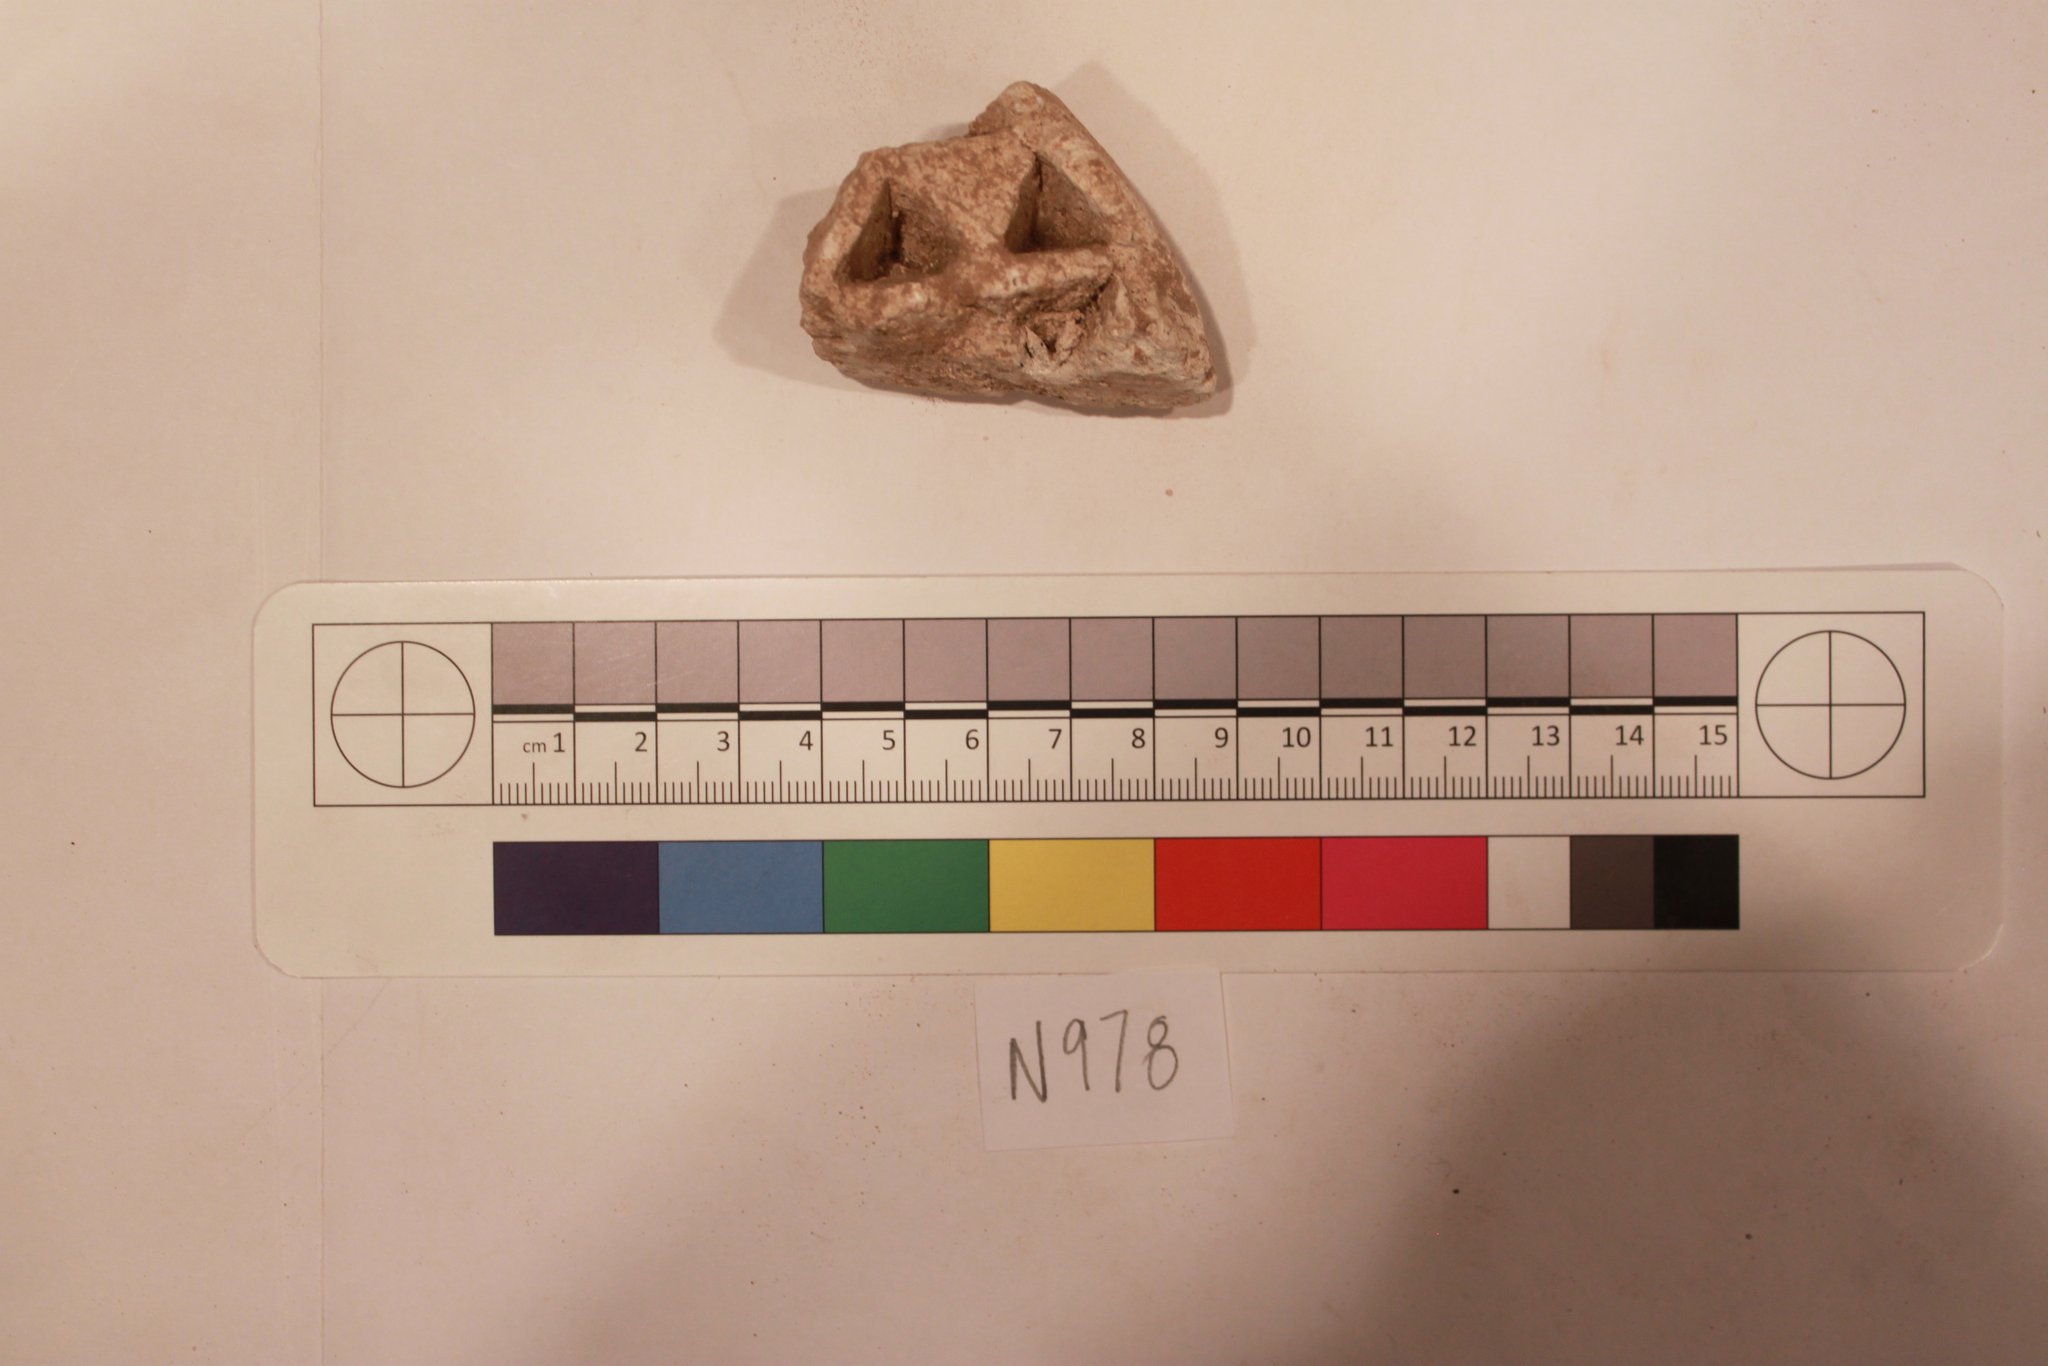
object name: fragment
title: Stucco Fragment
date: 701-1200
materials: plaster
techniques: carving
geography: iran